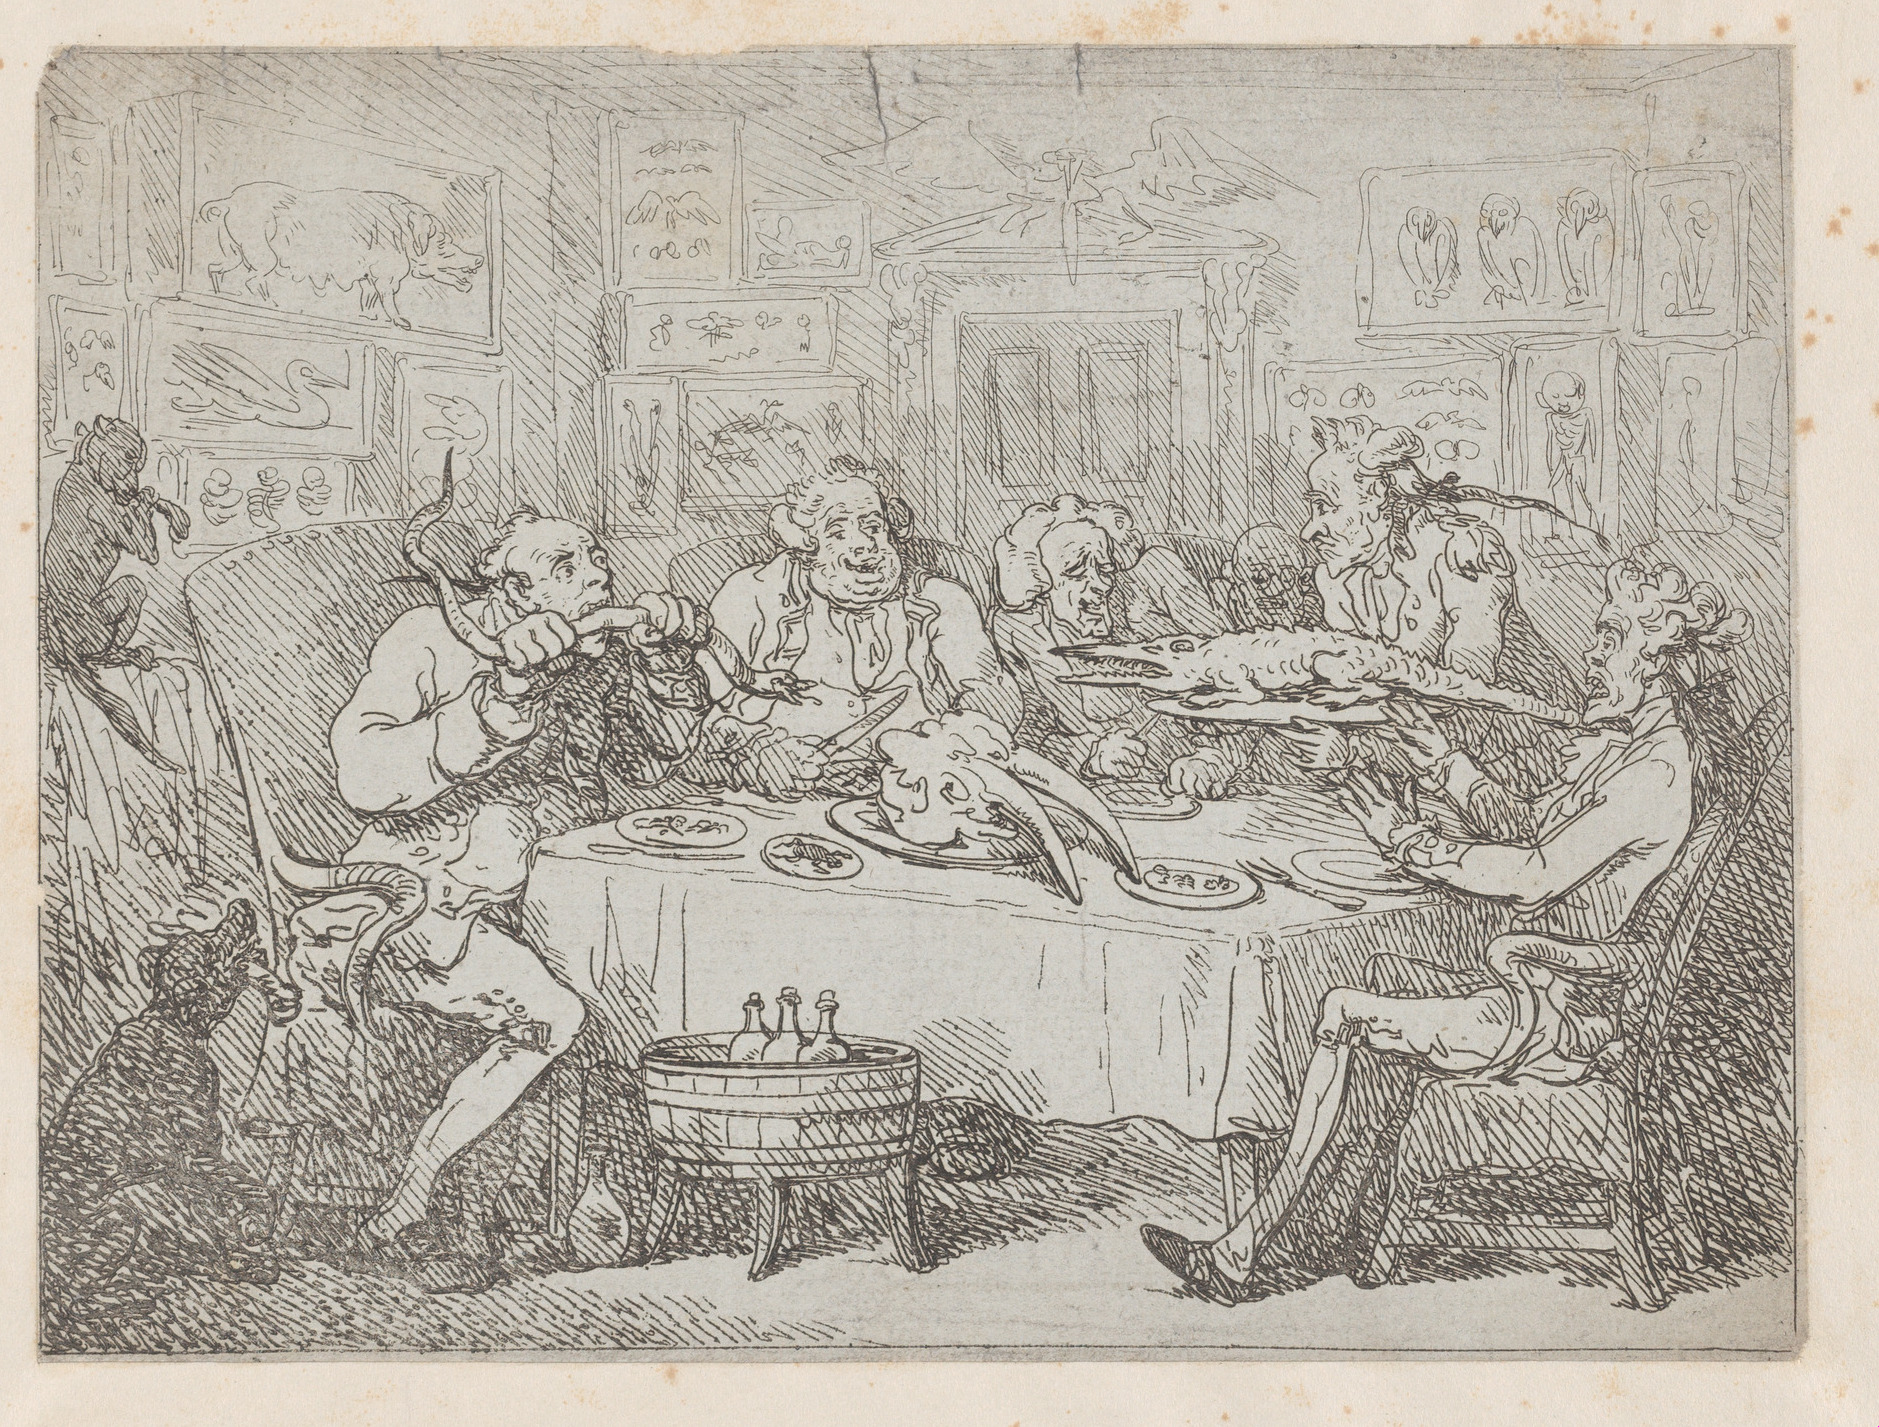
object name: print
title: The Banquet Scene: a Repast of the Acclimitative Order (Peter's Prophesy, or the President and the Poet)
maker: thomas rowlandson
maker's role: artist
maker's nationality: british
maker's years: 1757-1827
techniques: etching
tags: satire,men,snakes,dining,alligators